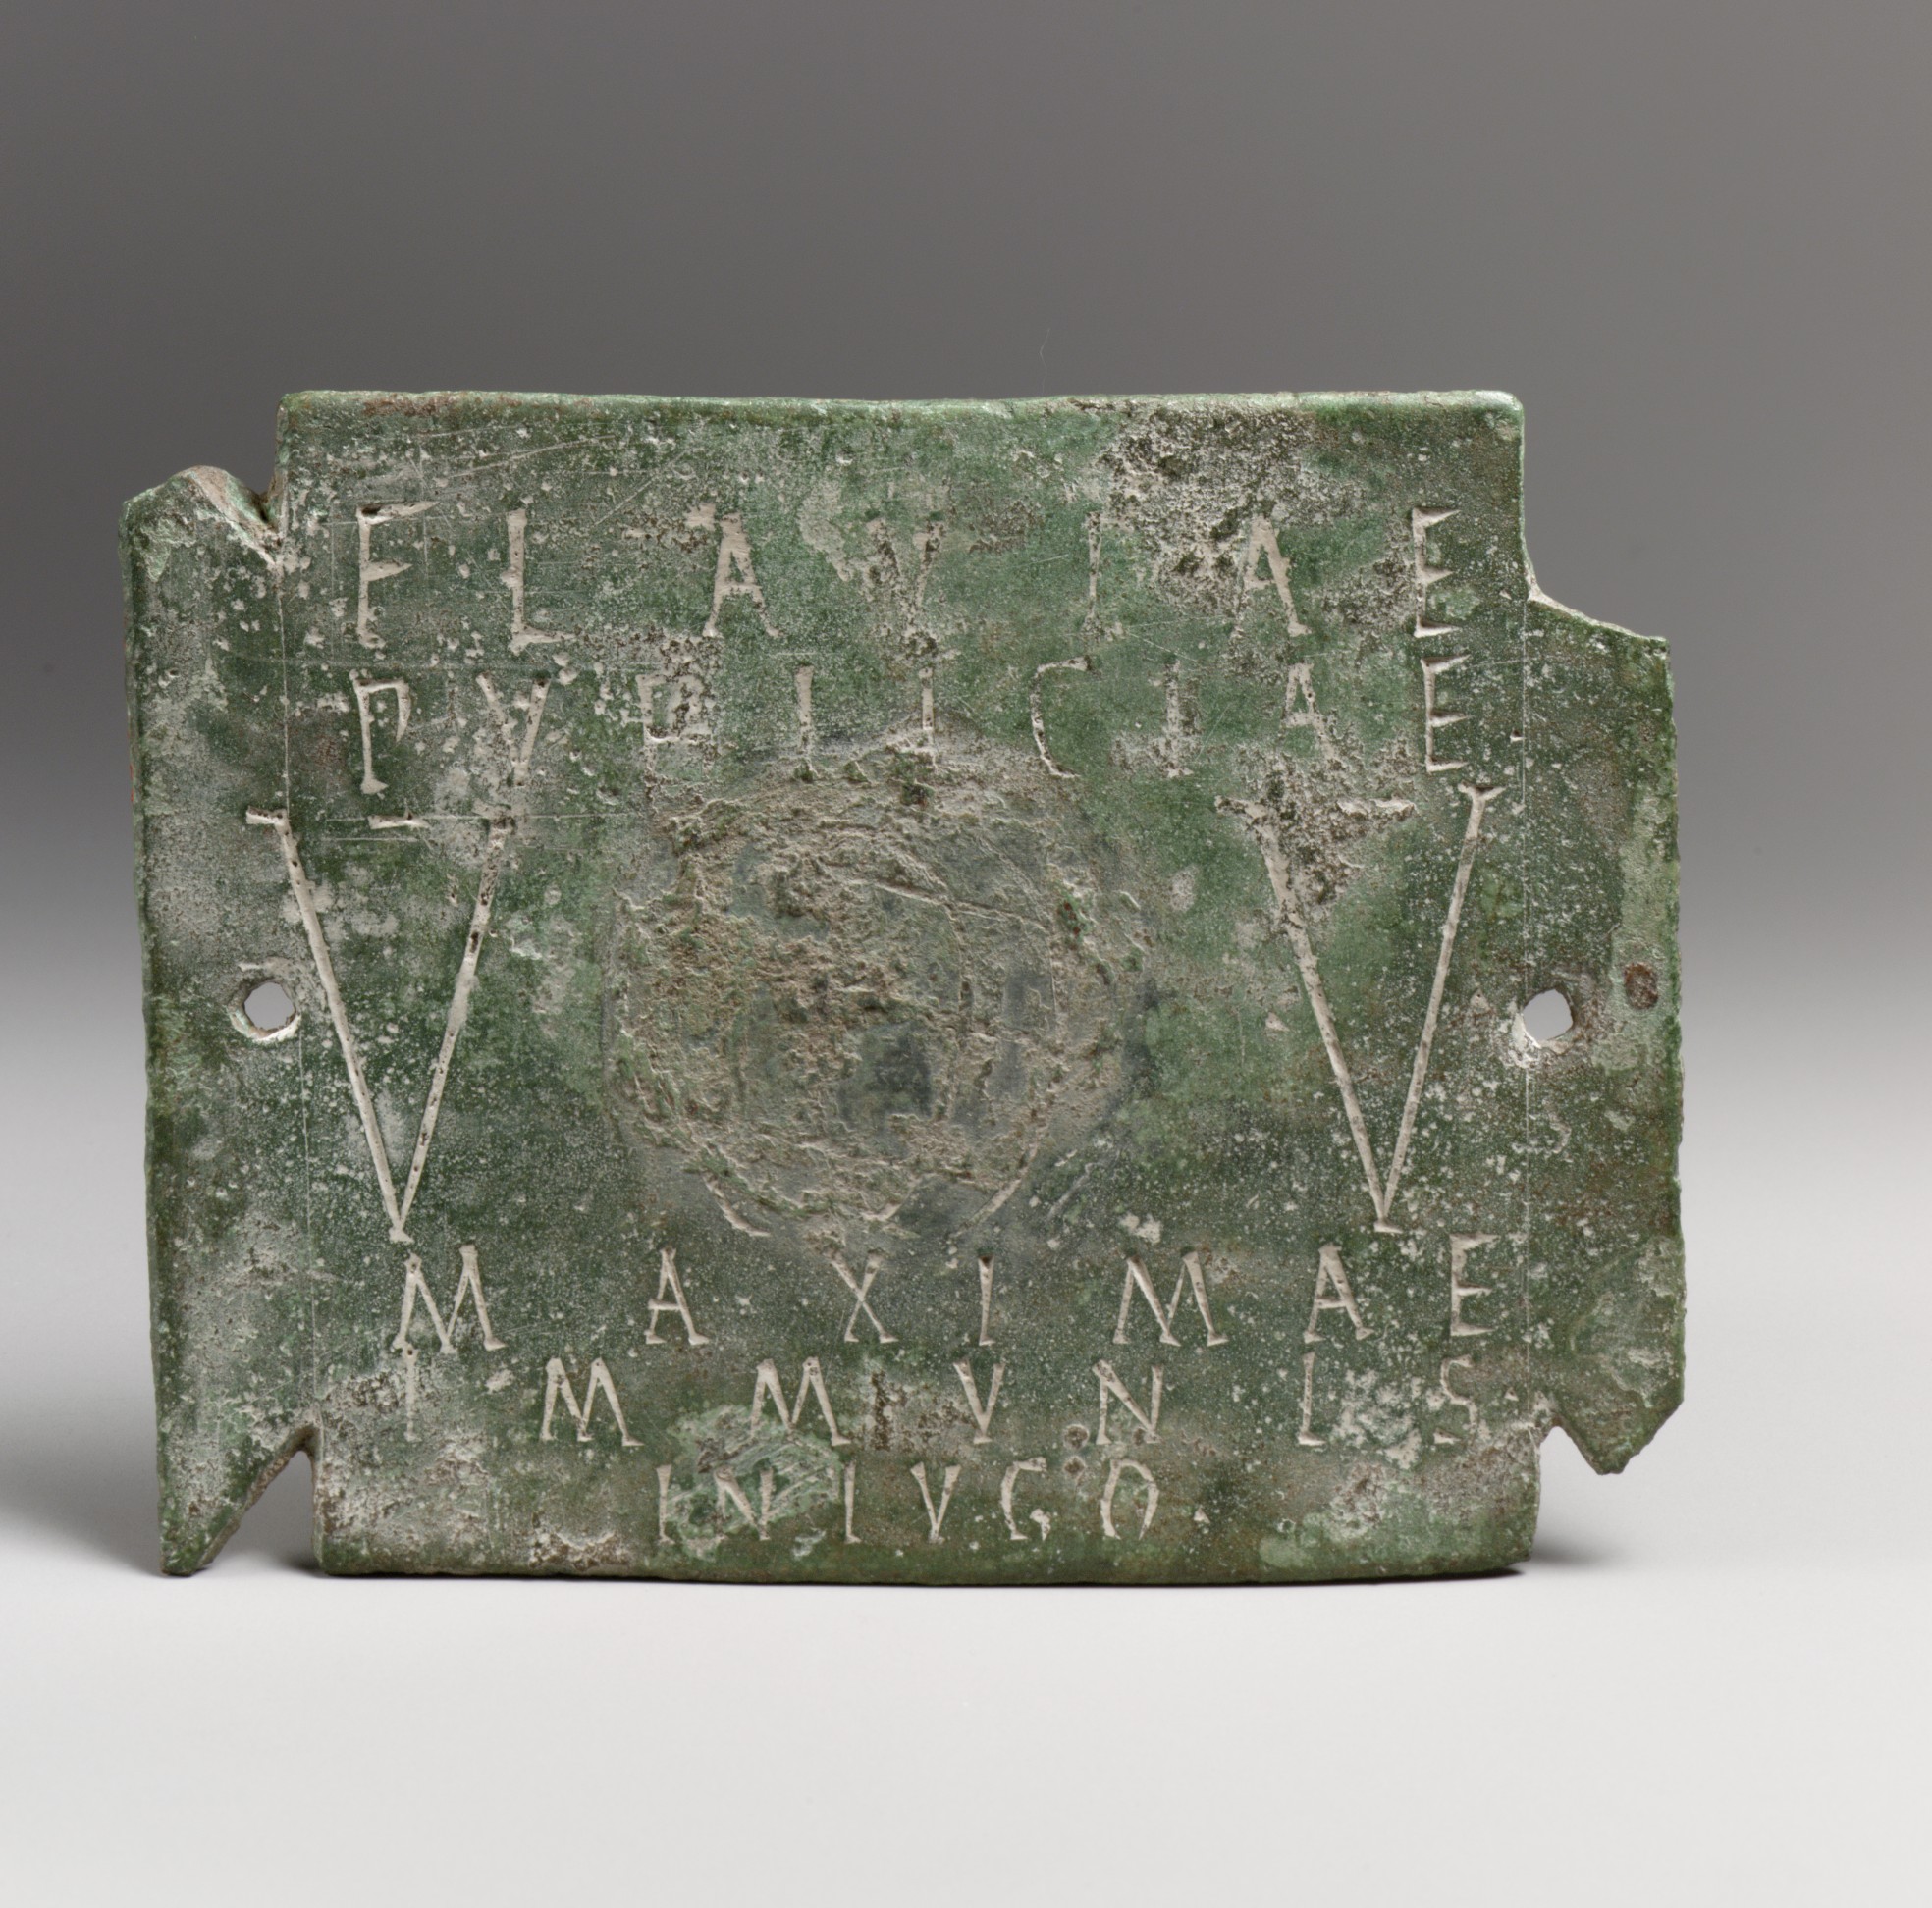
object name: plaque, apotropaic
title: Bronze plaque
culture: roman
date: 247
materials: bronze